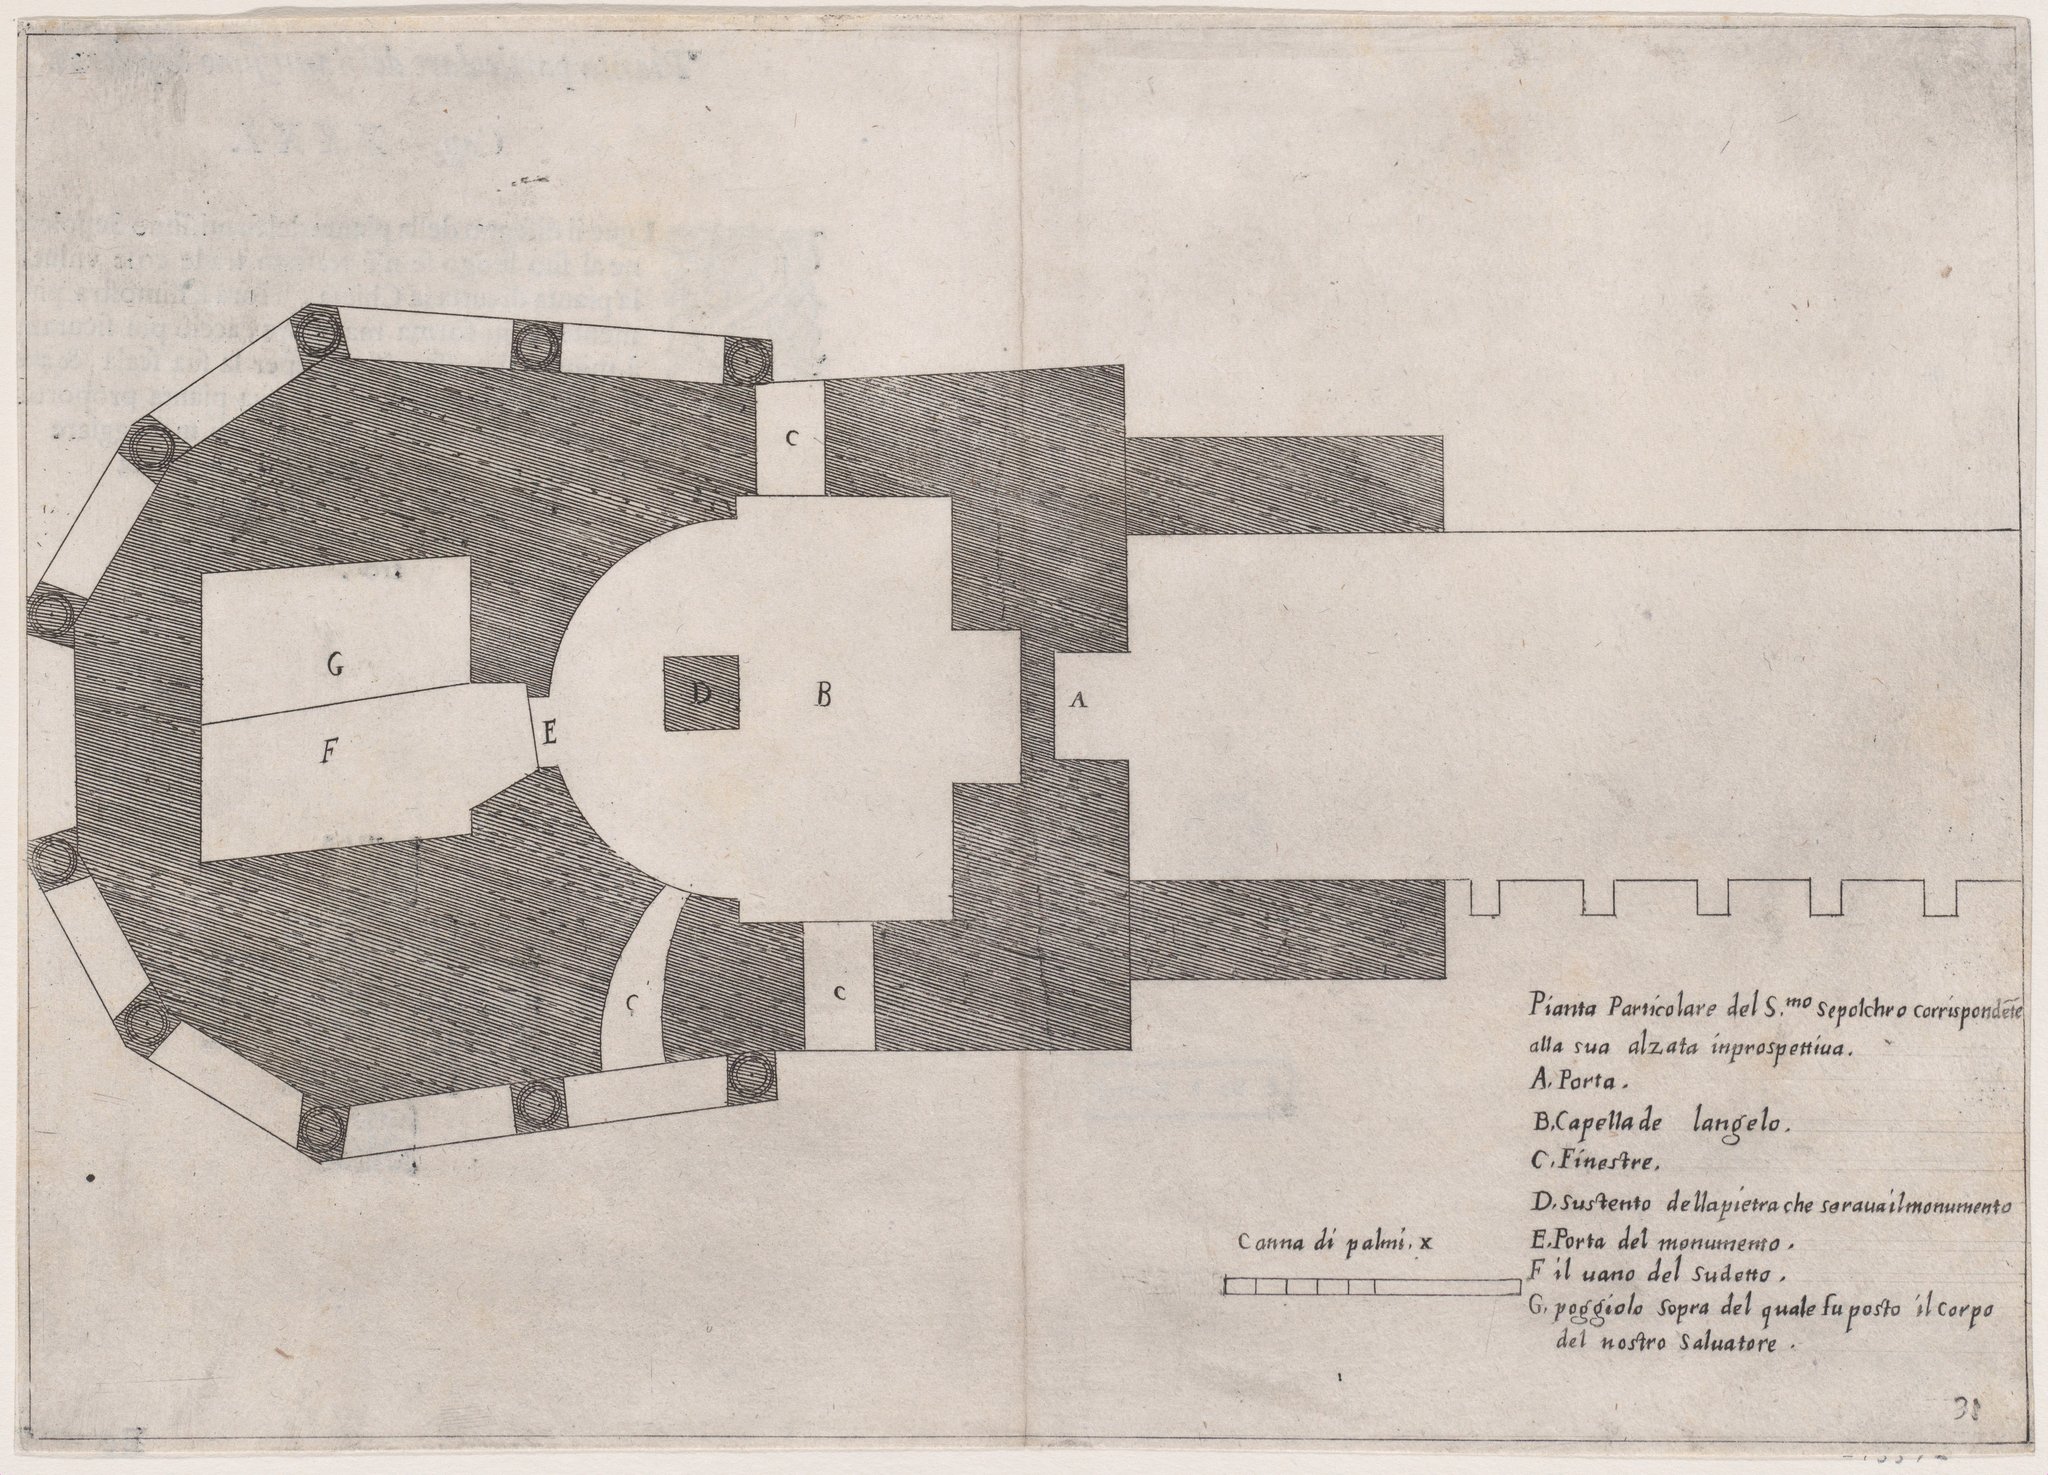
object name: print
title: Plate 24, from "Trattato delle Piante & Immagini de Sacri Edifizi di Terra Santa" (Treatise of the Plans & Images of the Sacred Buildings of the Holy Land)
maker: jacques callot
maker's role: artist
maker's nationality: french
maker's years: 1592-1635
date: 1620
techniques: engraving, etching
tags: architecture,buildings